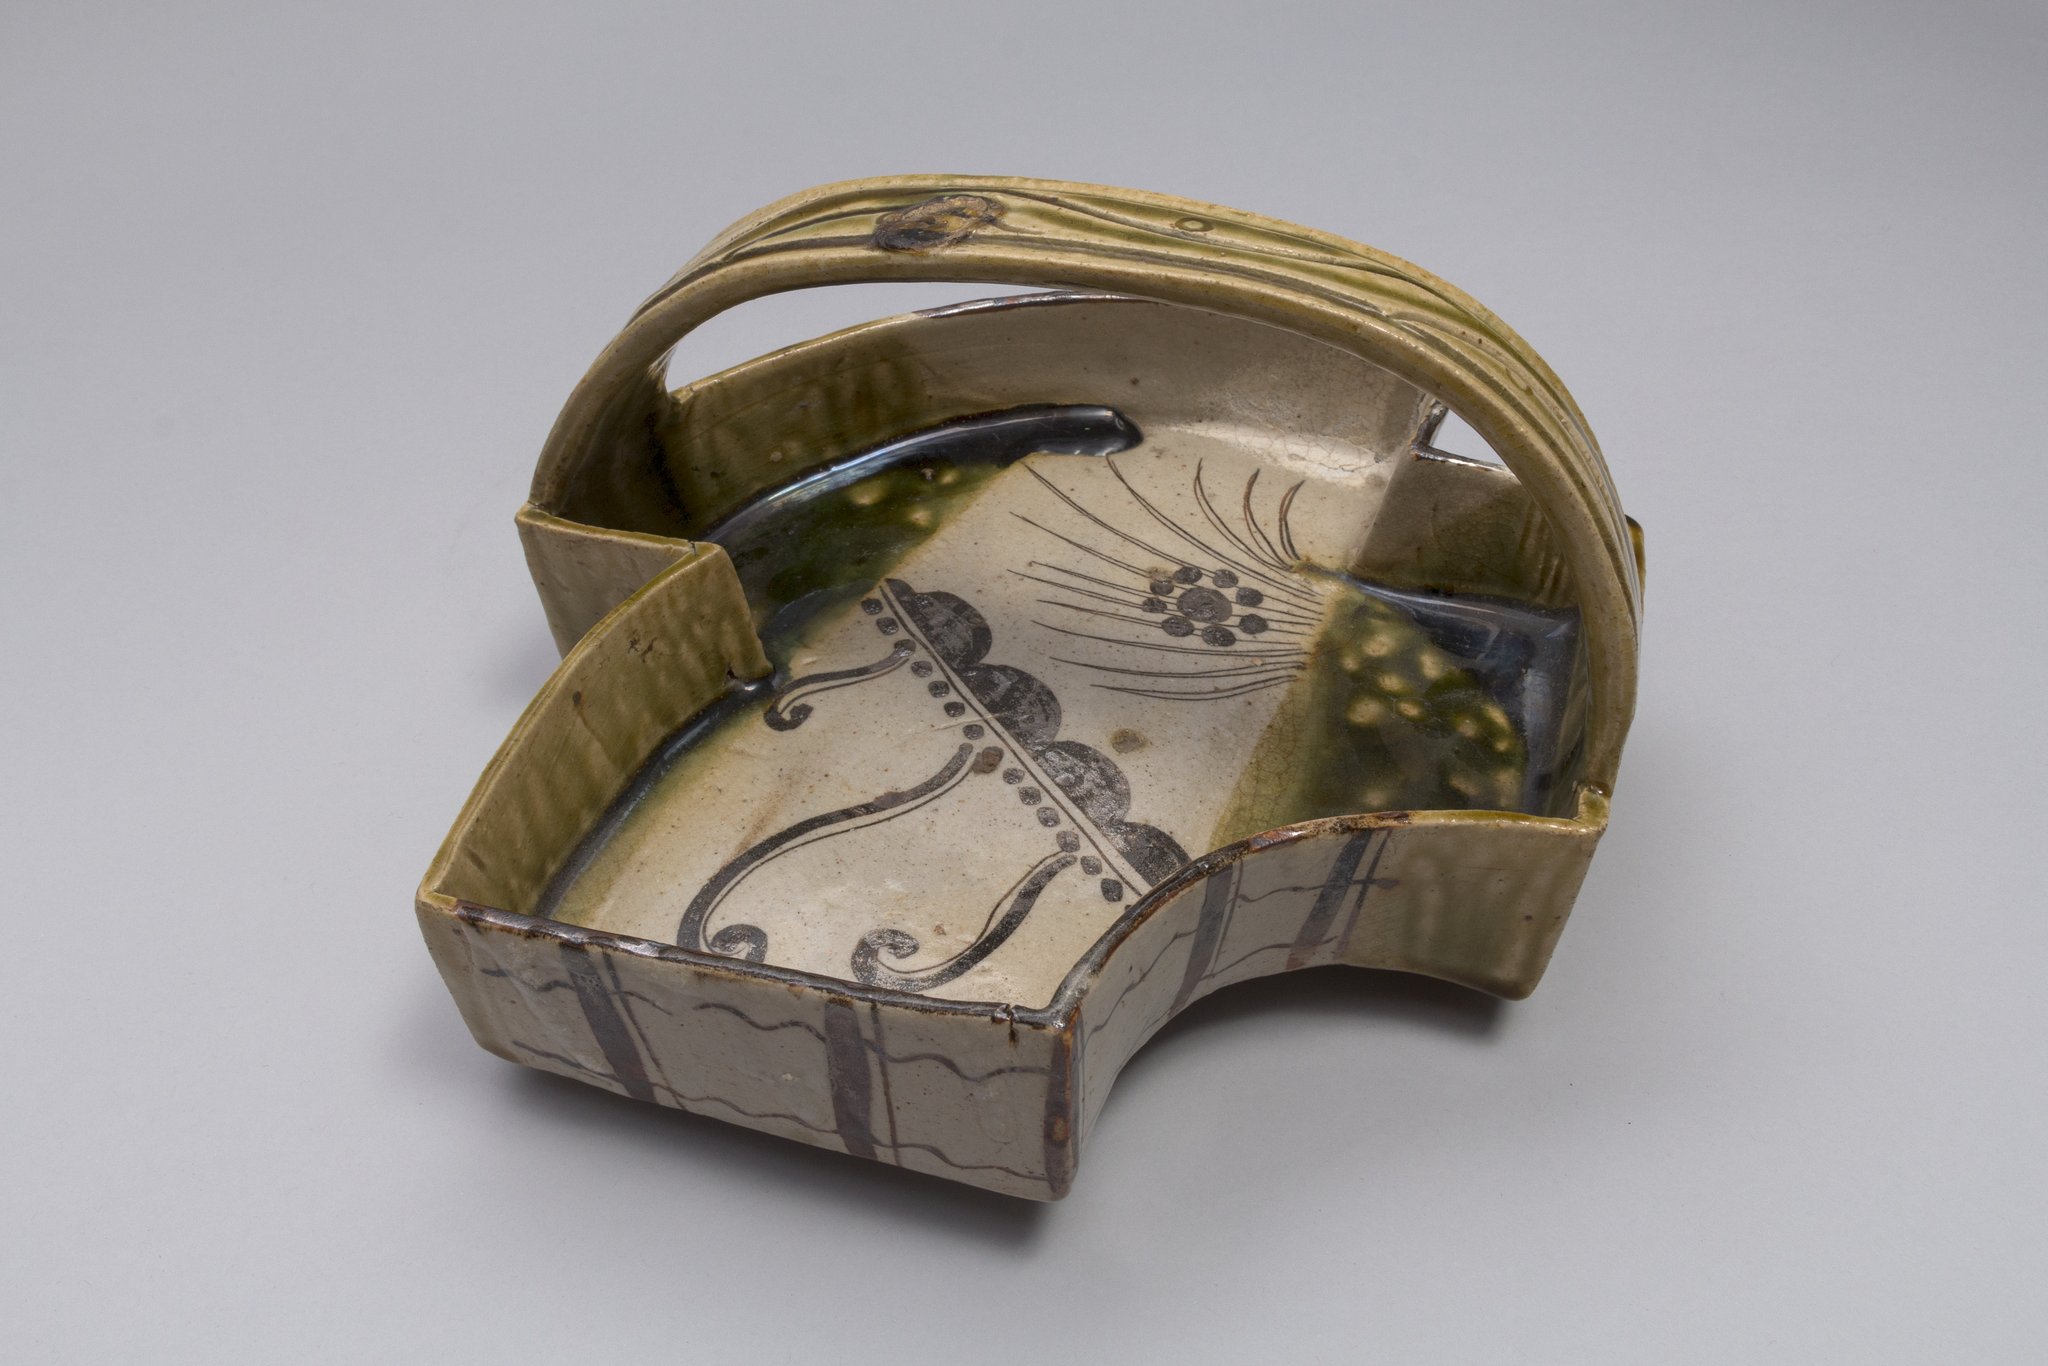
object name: dish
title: Dish in the Shape of a Double Fan with Arched Handle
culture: japanese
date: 1567-1633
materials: copper, glaze, iron, stoneware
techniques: underglaze